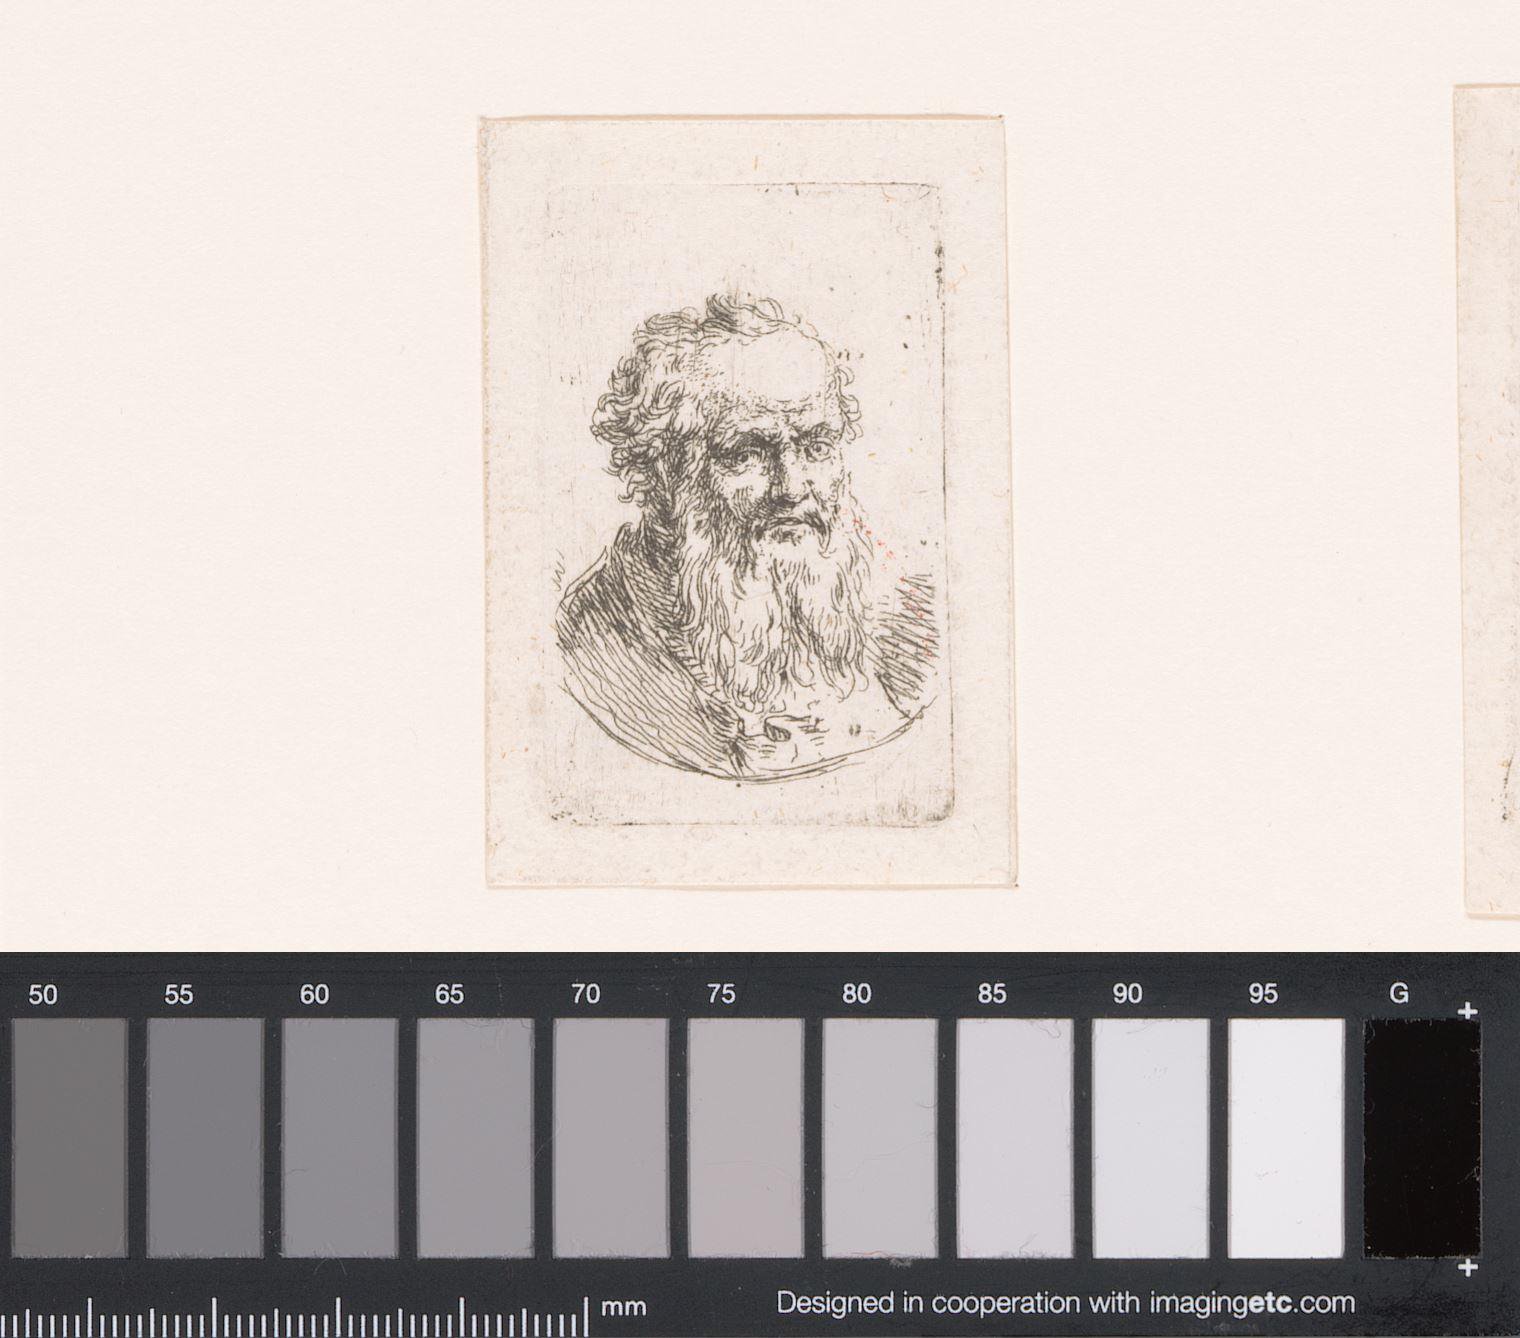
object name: print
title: Kop van oude man met baard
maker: Anonymous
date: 1700-1799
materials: paper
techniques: etching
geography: germany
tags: old man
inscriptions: collector's mark: Lugt 240